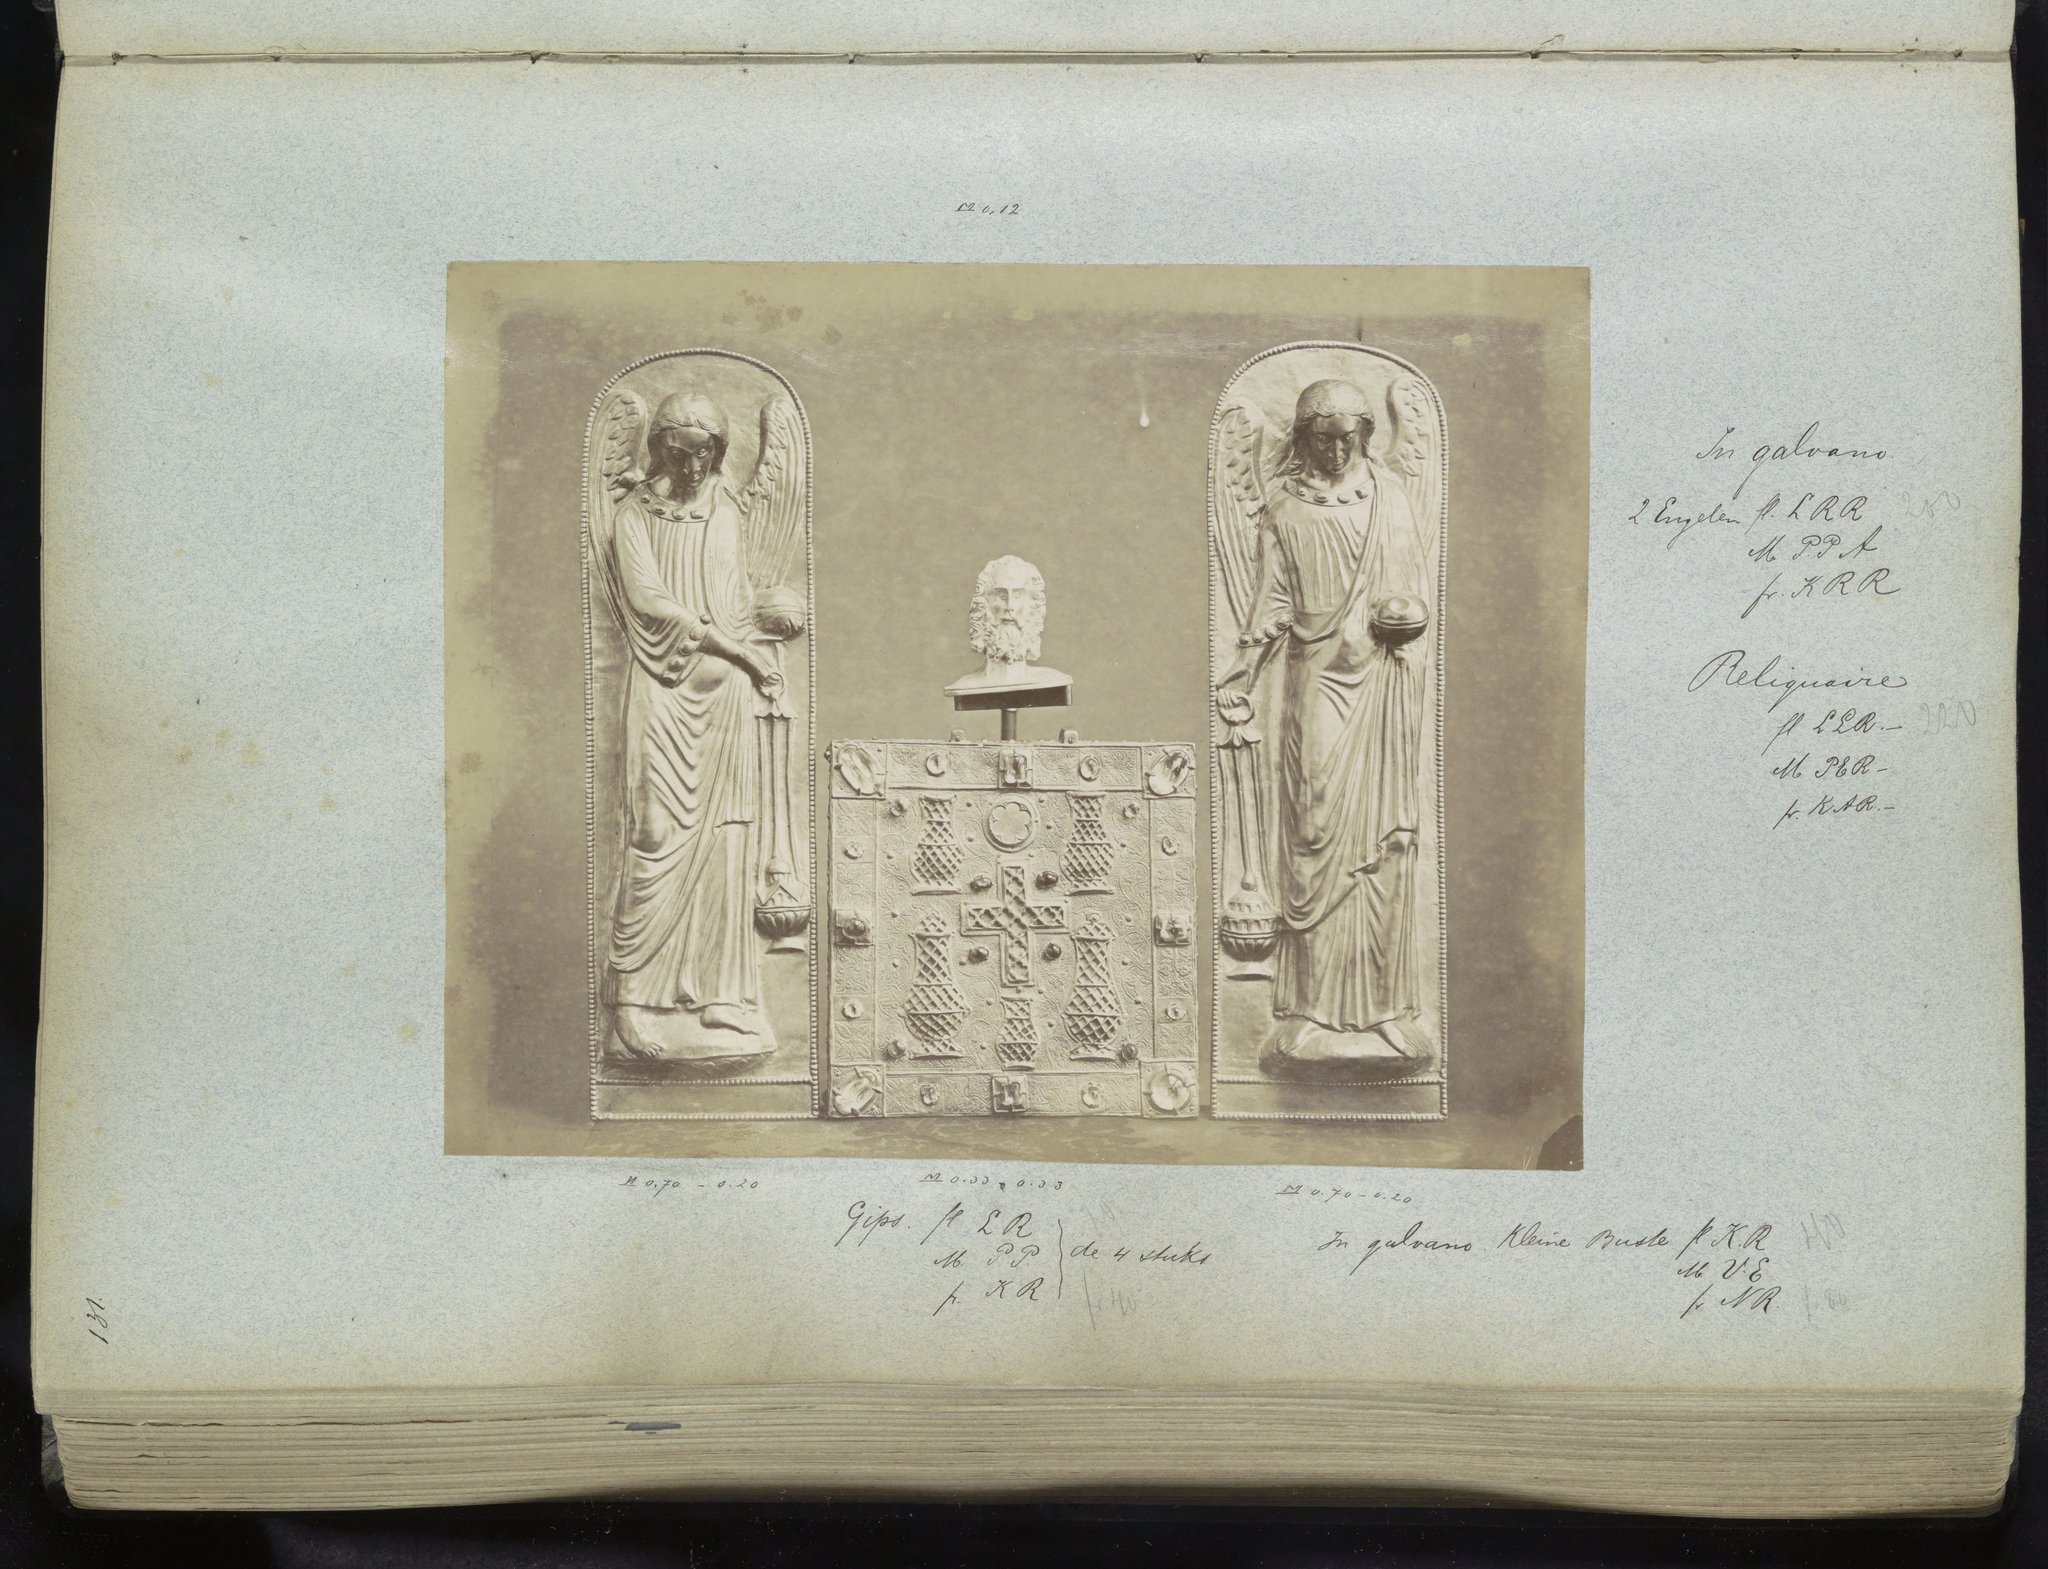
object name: album leaf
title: Gipsen afgietsels van een buste en twee engelen, vermoedelijk van een reliekschrijn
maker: Anonymous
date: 1875-1900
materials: paper, photographic support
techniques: albumen print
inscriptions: annotation, annotation: ‘2 Engelen / Reliquaire / Gips / Kleine Buste’, annotation